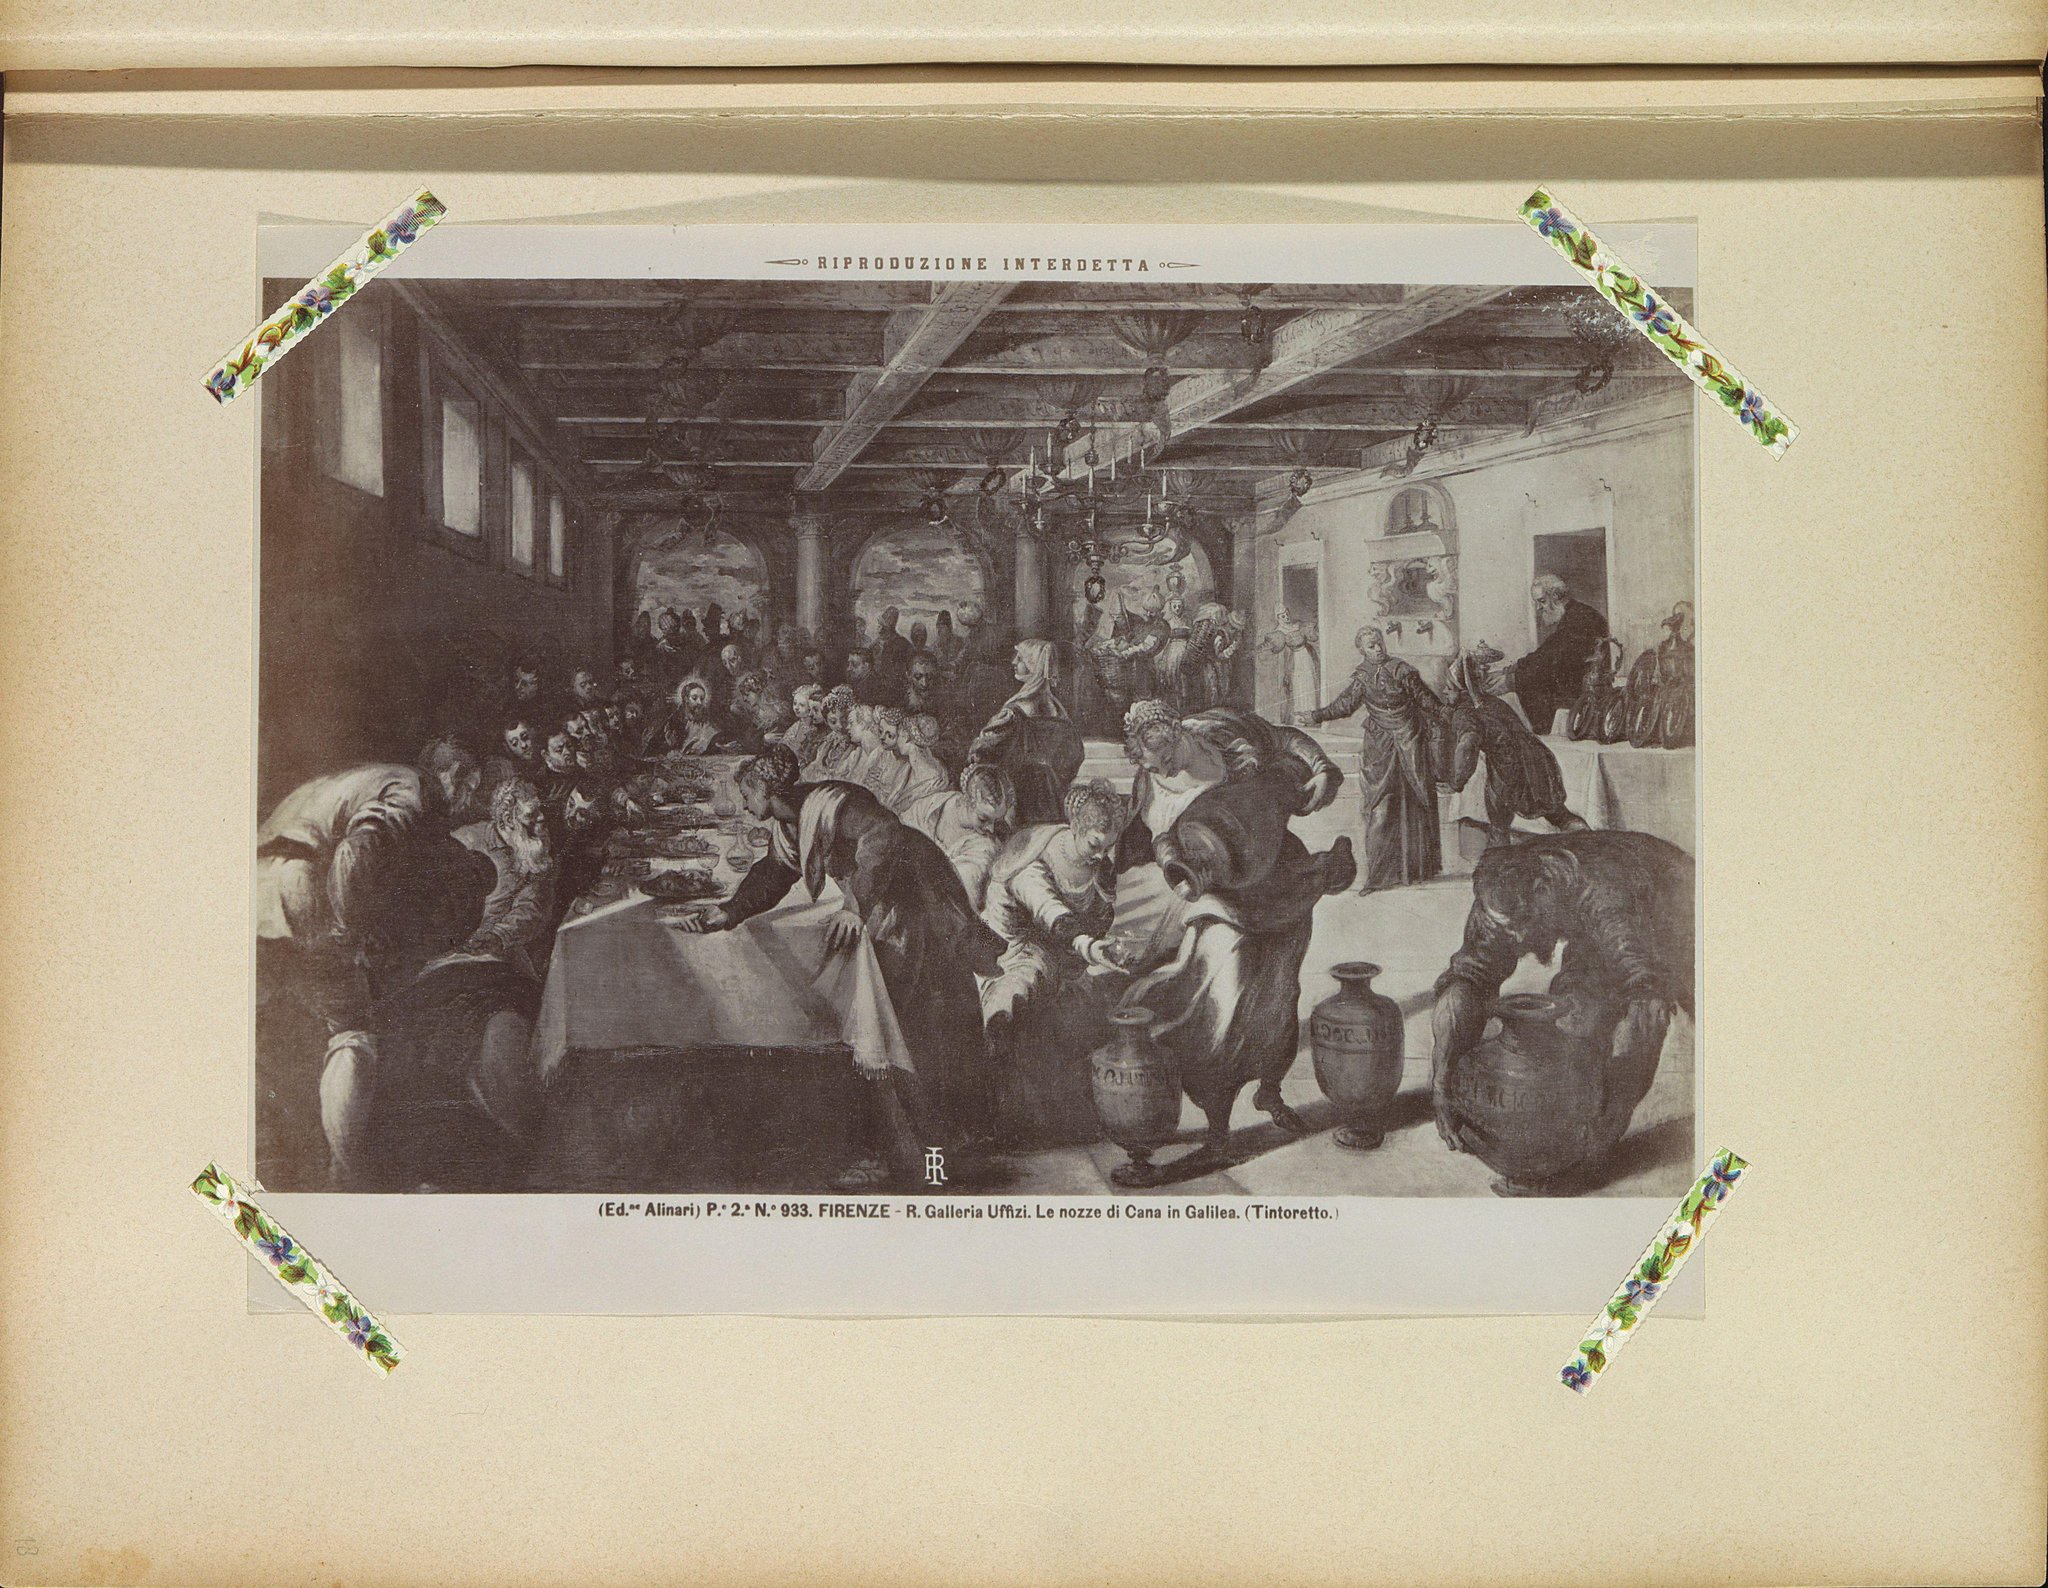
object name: photograph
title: Firenze - R. Galleria Uffizi. Le nozze di Cana in Galilea. (Tintoretto.)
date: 1860-1900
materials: photographic support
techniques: albumen print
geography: italy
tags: the marriage-feast at cana (john 2:1-11)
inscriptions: inscription: ‘IR’, number: ‘P.e.2.a No. 933’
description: Onderdeel van Fotoalbum met opnames van bezienswaardigheden in Italiaanse steden en van kunstwerken.